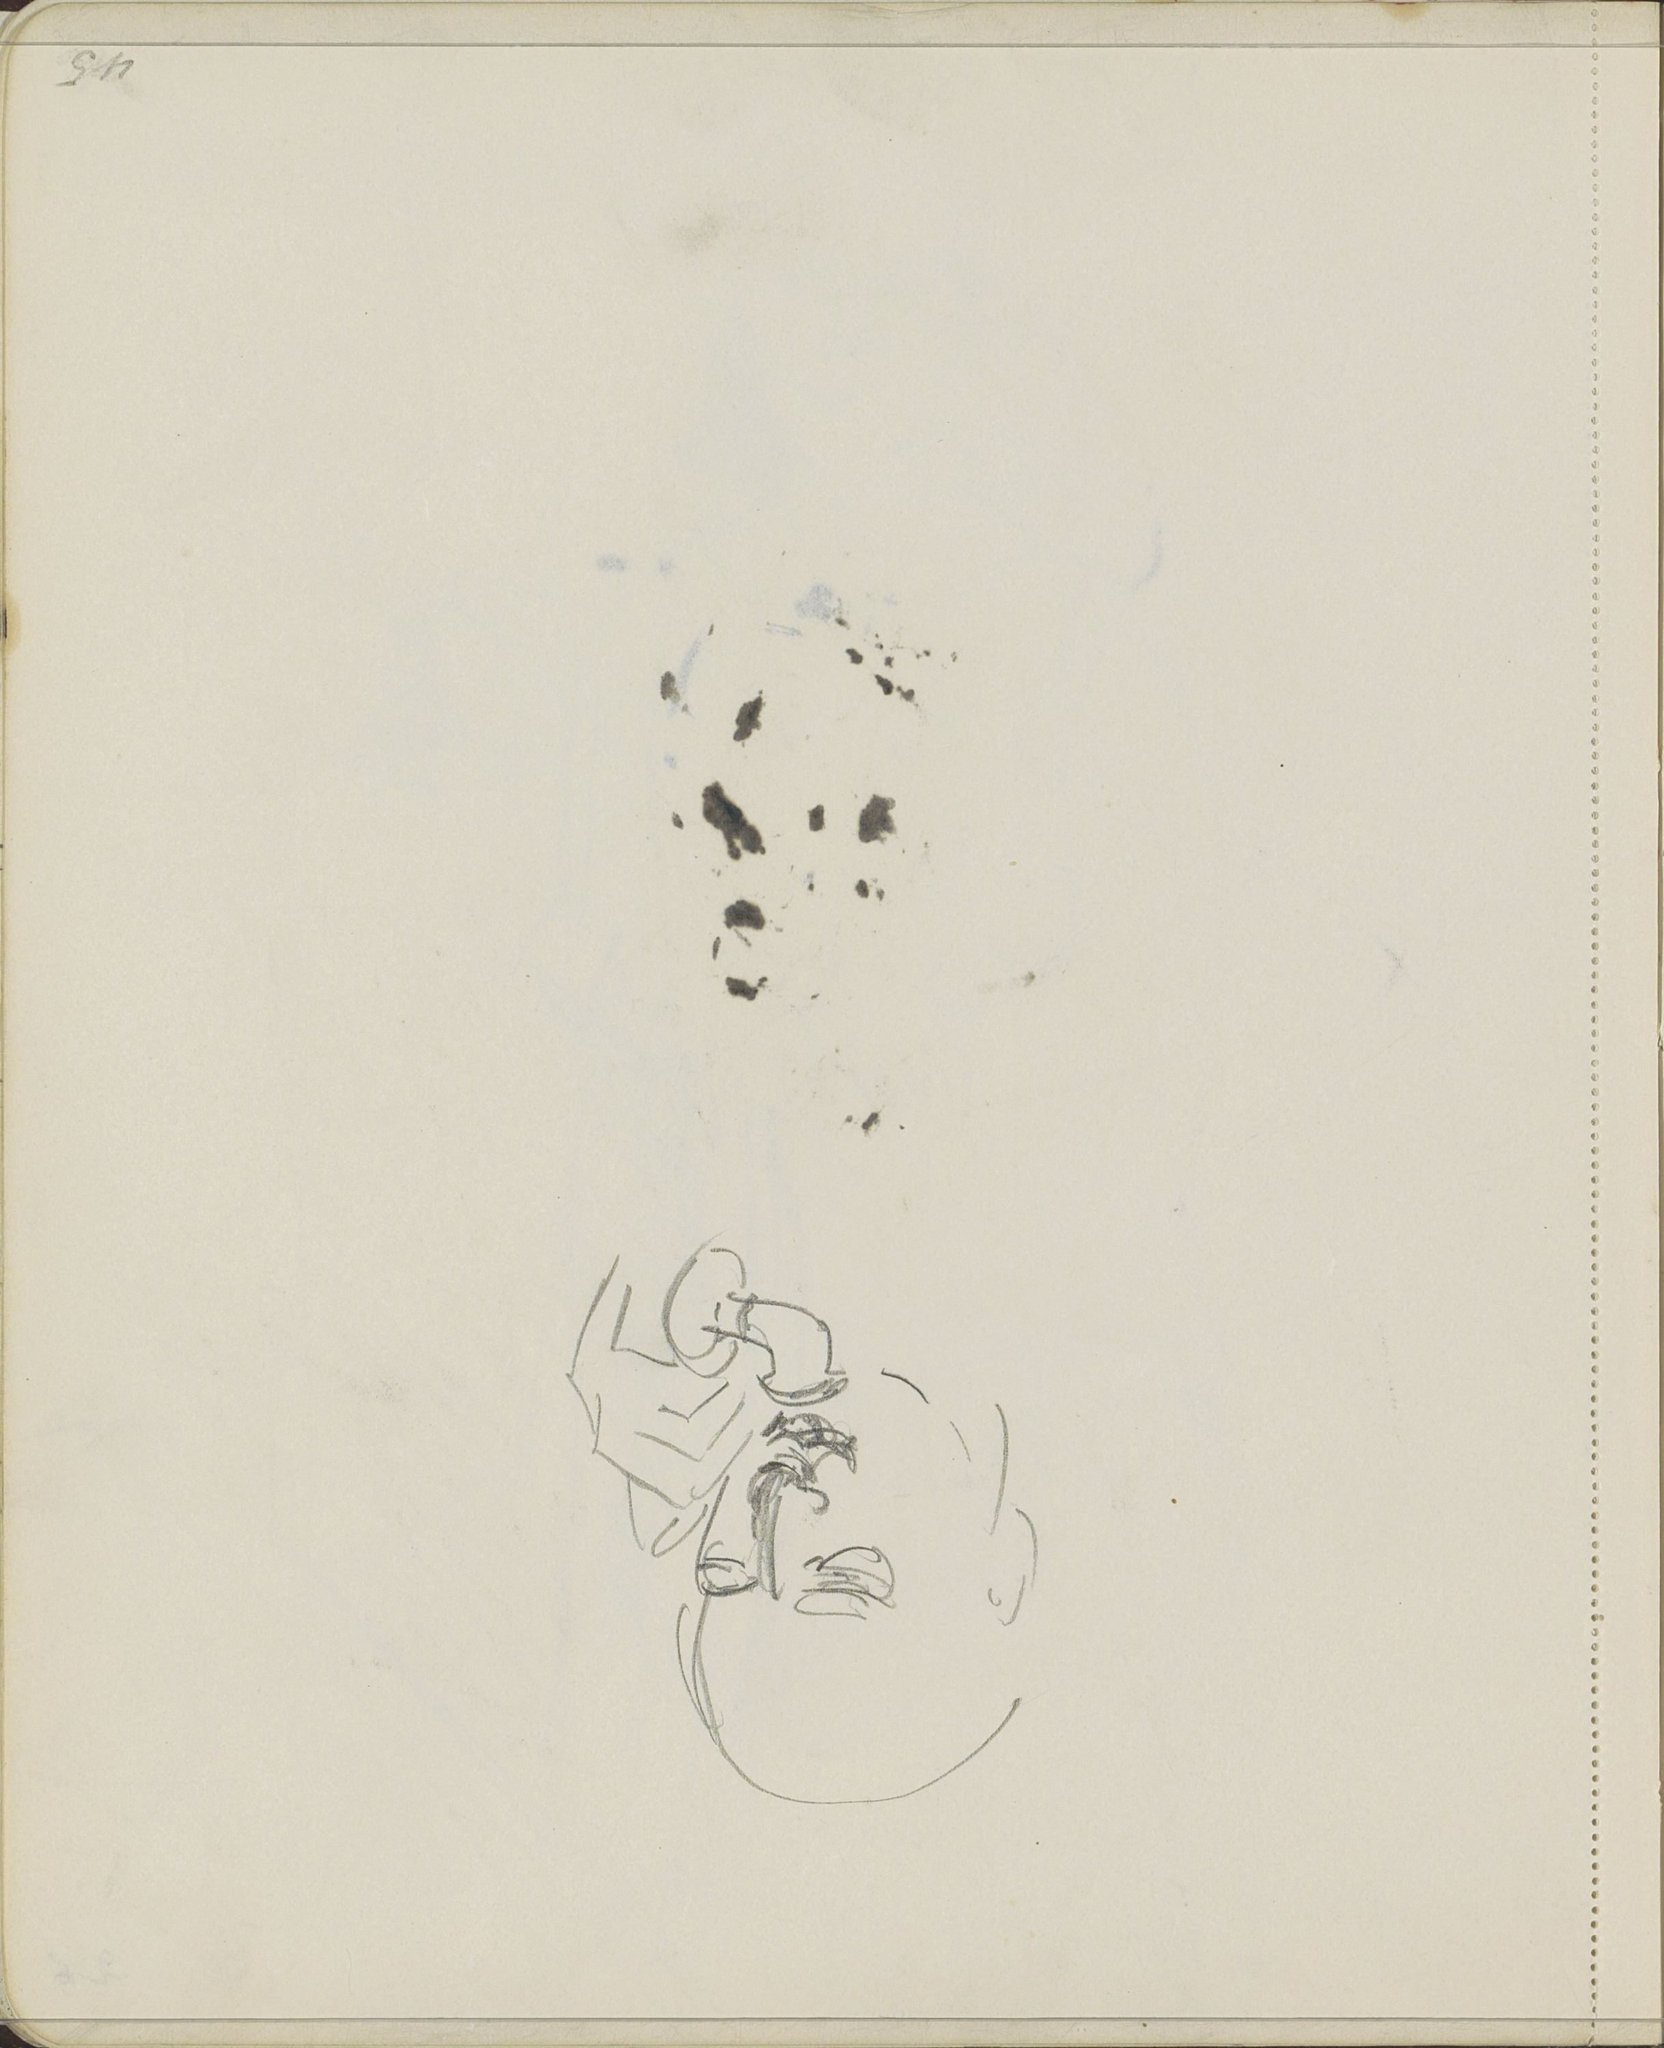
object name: sketchbook leaf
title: Man aan de telefoon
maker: isaac israels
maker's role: draughtsman, painter, print maker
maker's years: 1865-1934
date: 1925-1934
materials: paper, pencil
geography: the hague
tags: head (human), telephone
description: Blad 26 verso uit schetsboek XXVI met 35 bladen.